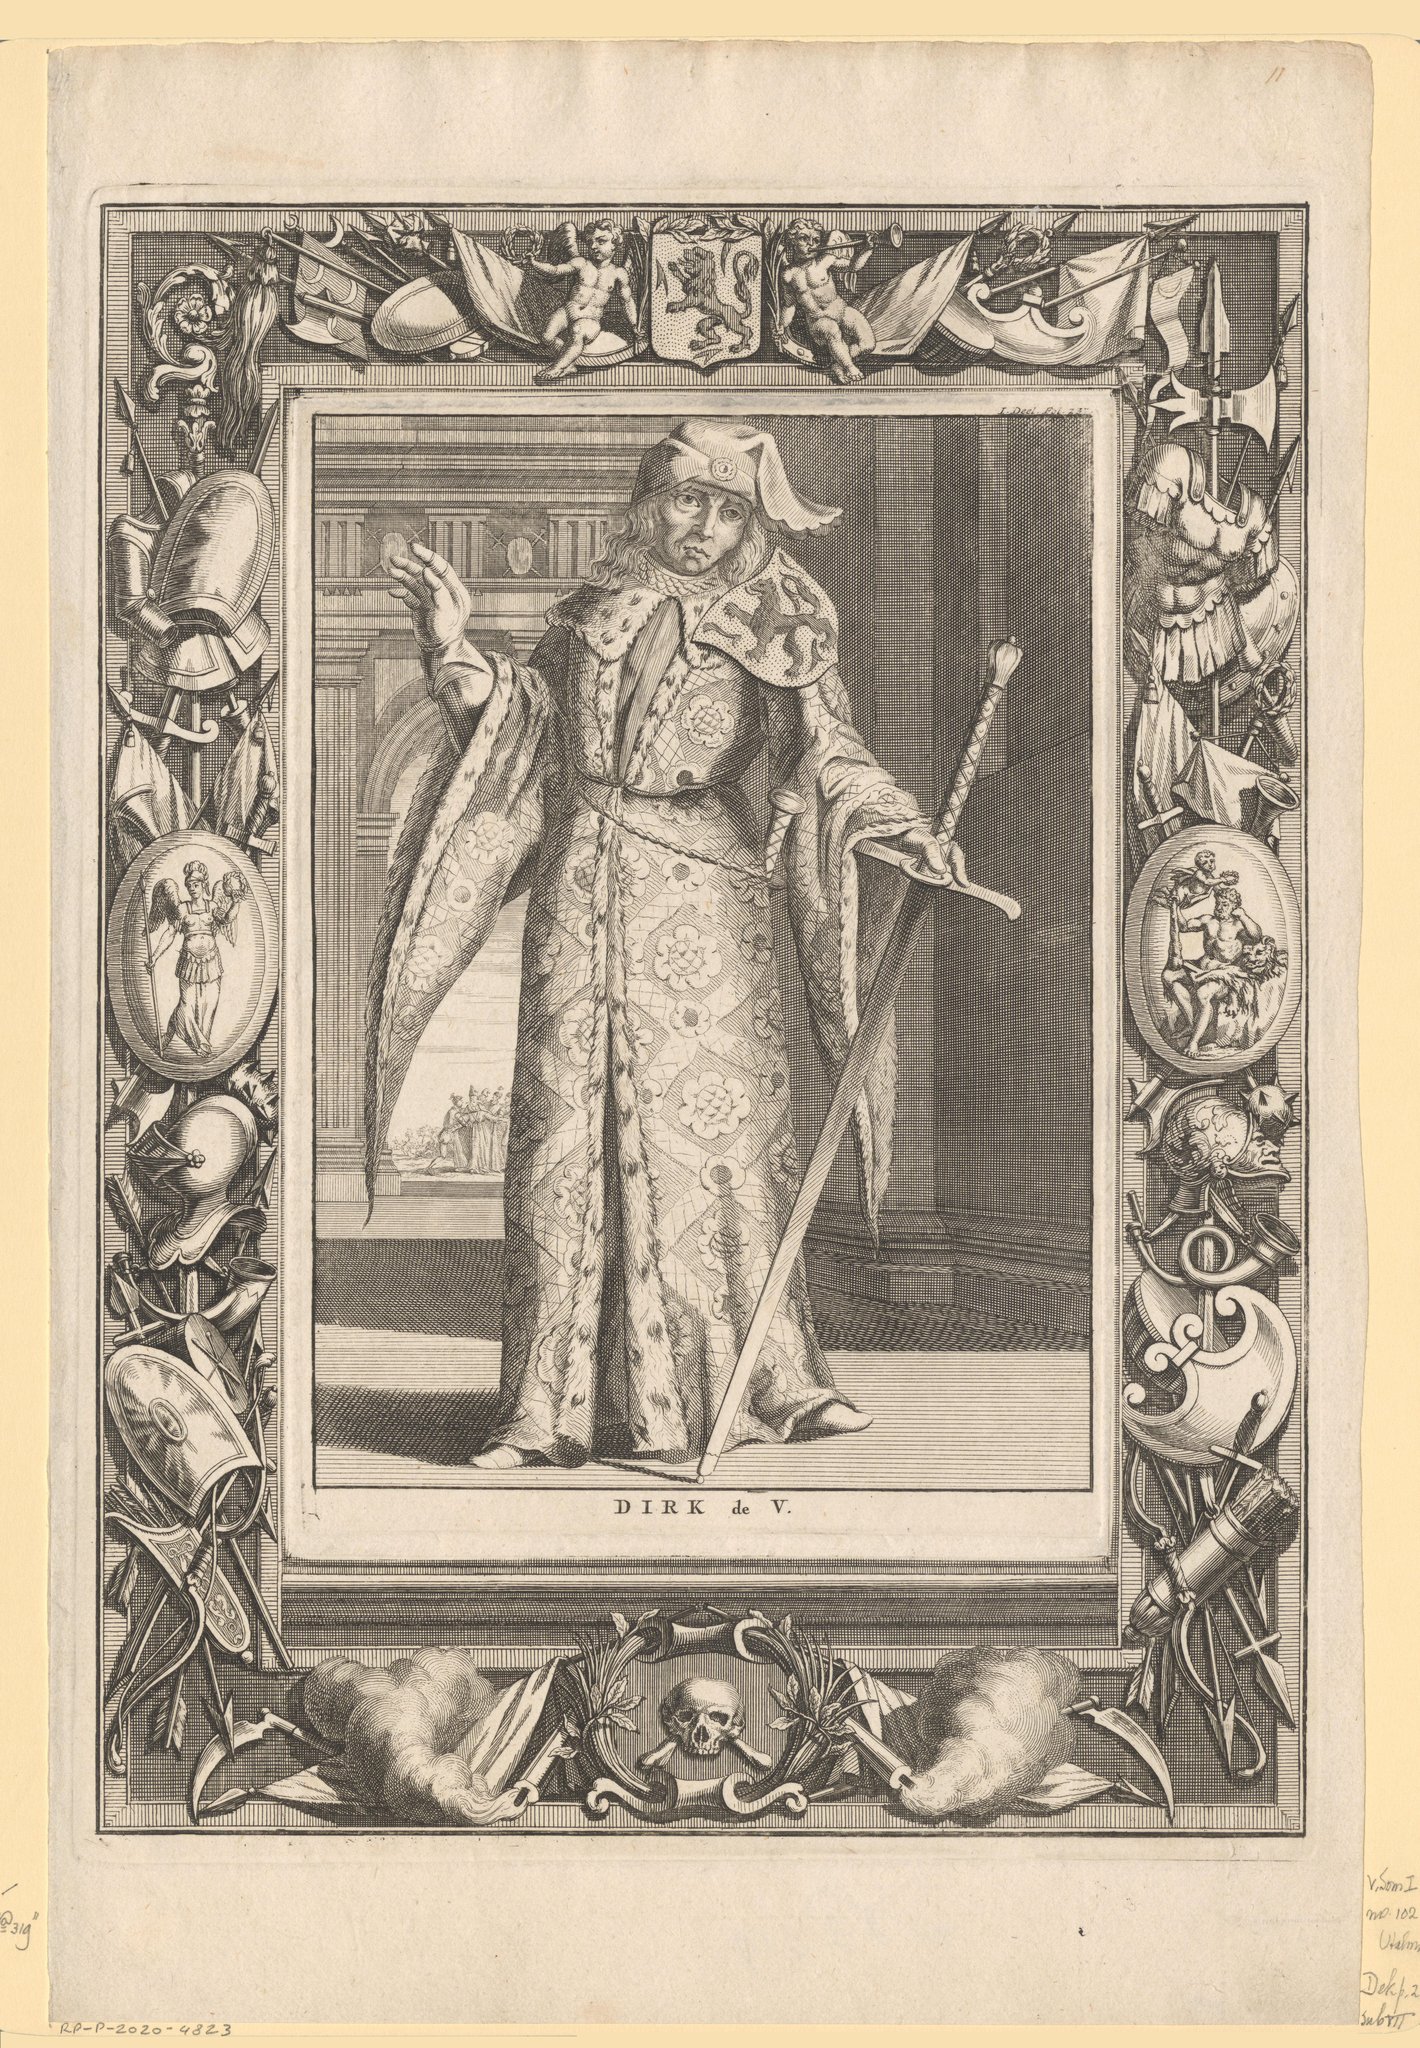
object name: print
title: Portret van Dirk V, graaf van Holland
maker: Anonymous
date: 1725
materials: paper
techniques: engraving, etching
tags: (story of) hercules (heracles), historical persons, hacking and thrusting weapons: sword, ruler, sovereign, armorial bearing, heraldry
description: Prent mogelijk uit: Halma, François. Tooneel der Vereenigde Nederlanden, en onderhorige landschappen (...). 2 dln. Leeuwarden: Hendrik Halma, 1725, dl. 1, fol. 237. Eerdere staat van prent gebruikt in: Stoke, Melis. Hollandse jaar-boeken of rijm-kronijk van Melis Stoke. Behelsende de geschiedenissen des lands (...). Leiden: Johannes du Vivié en Isaak Severinus, 1699.